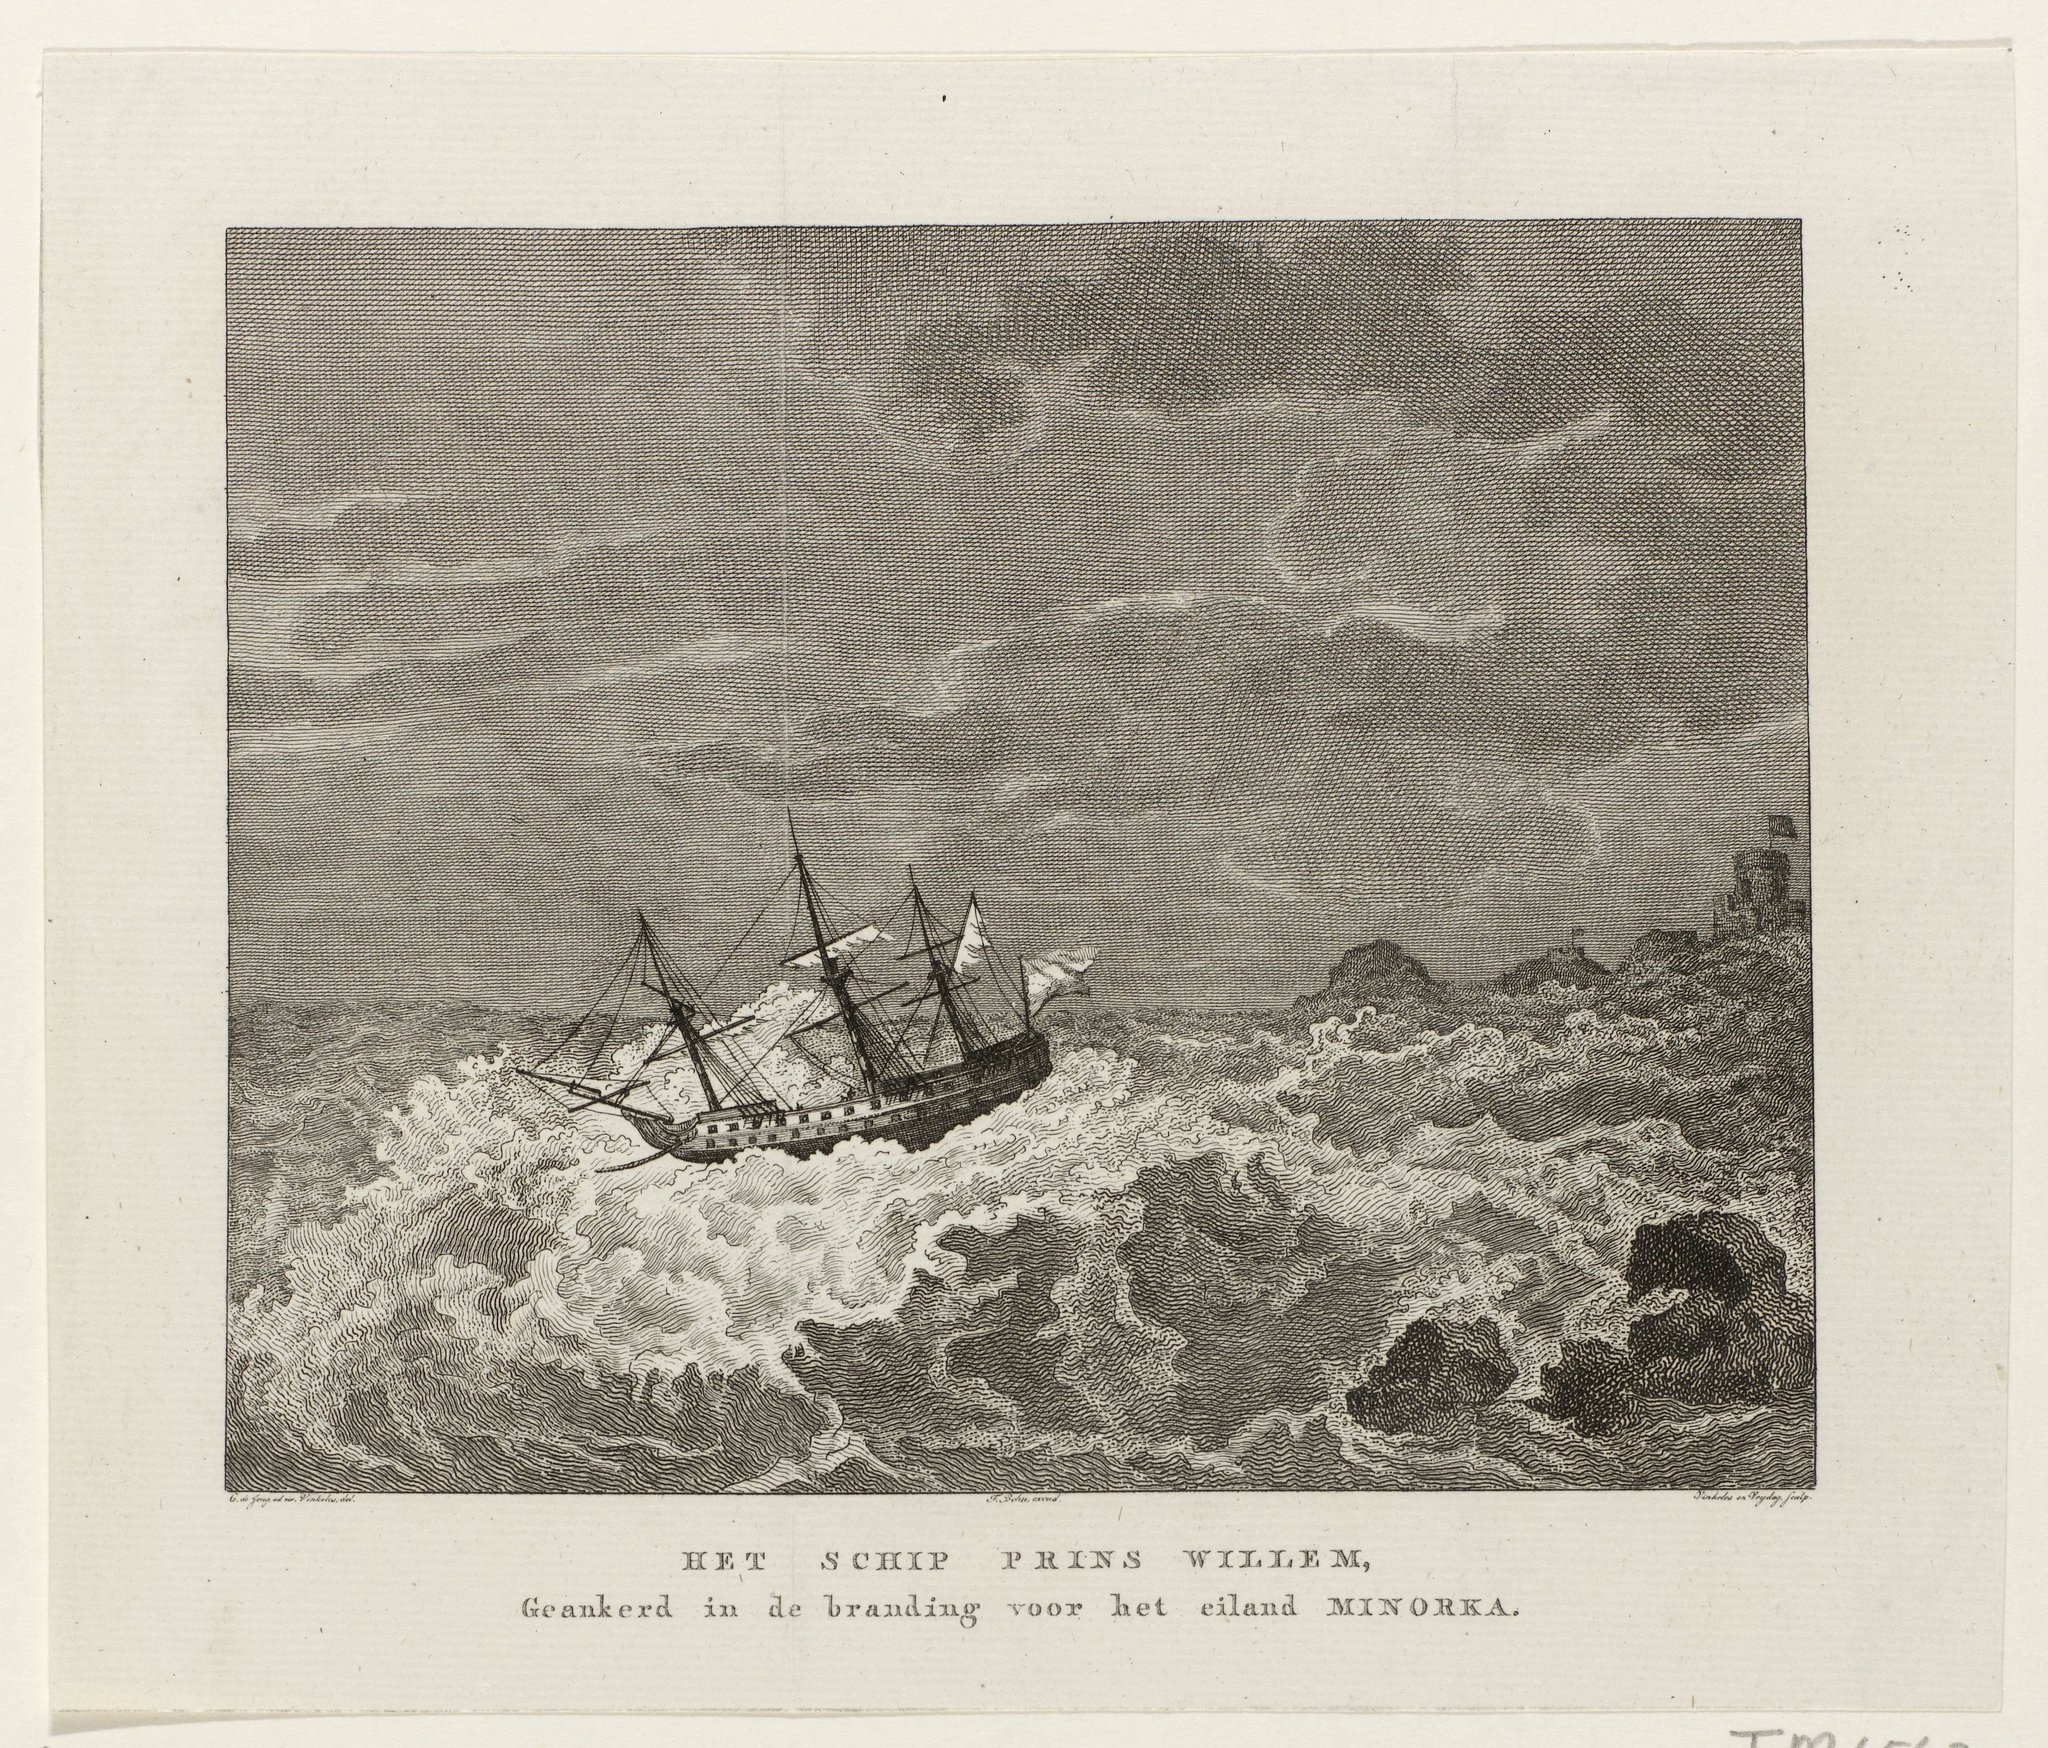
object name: print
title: Het schip Prins Willem, Geankerd in de branding voor het eiland Minorka.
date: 1784-1786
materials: paper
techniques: engraving, etching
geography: northern netherlands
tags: shipwreck (+ propulsion of vehicle, ship, etc. by wind)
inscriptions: collector's mark: Lugt 2228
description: Het oorlogsschip Prins Willem, onder bevel van kapitein C. van Gennep, geankered voor de kust van Menorca tijdens de storm op 3 februari 1784.